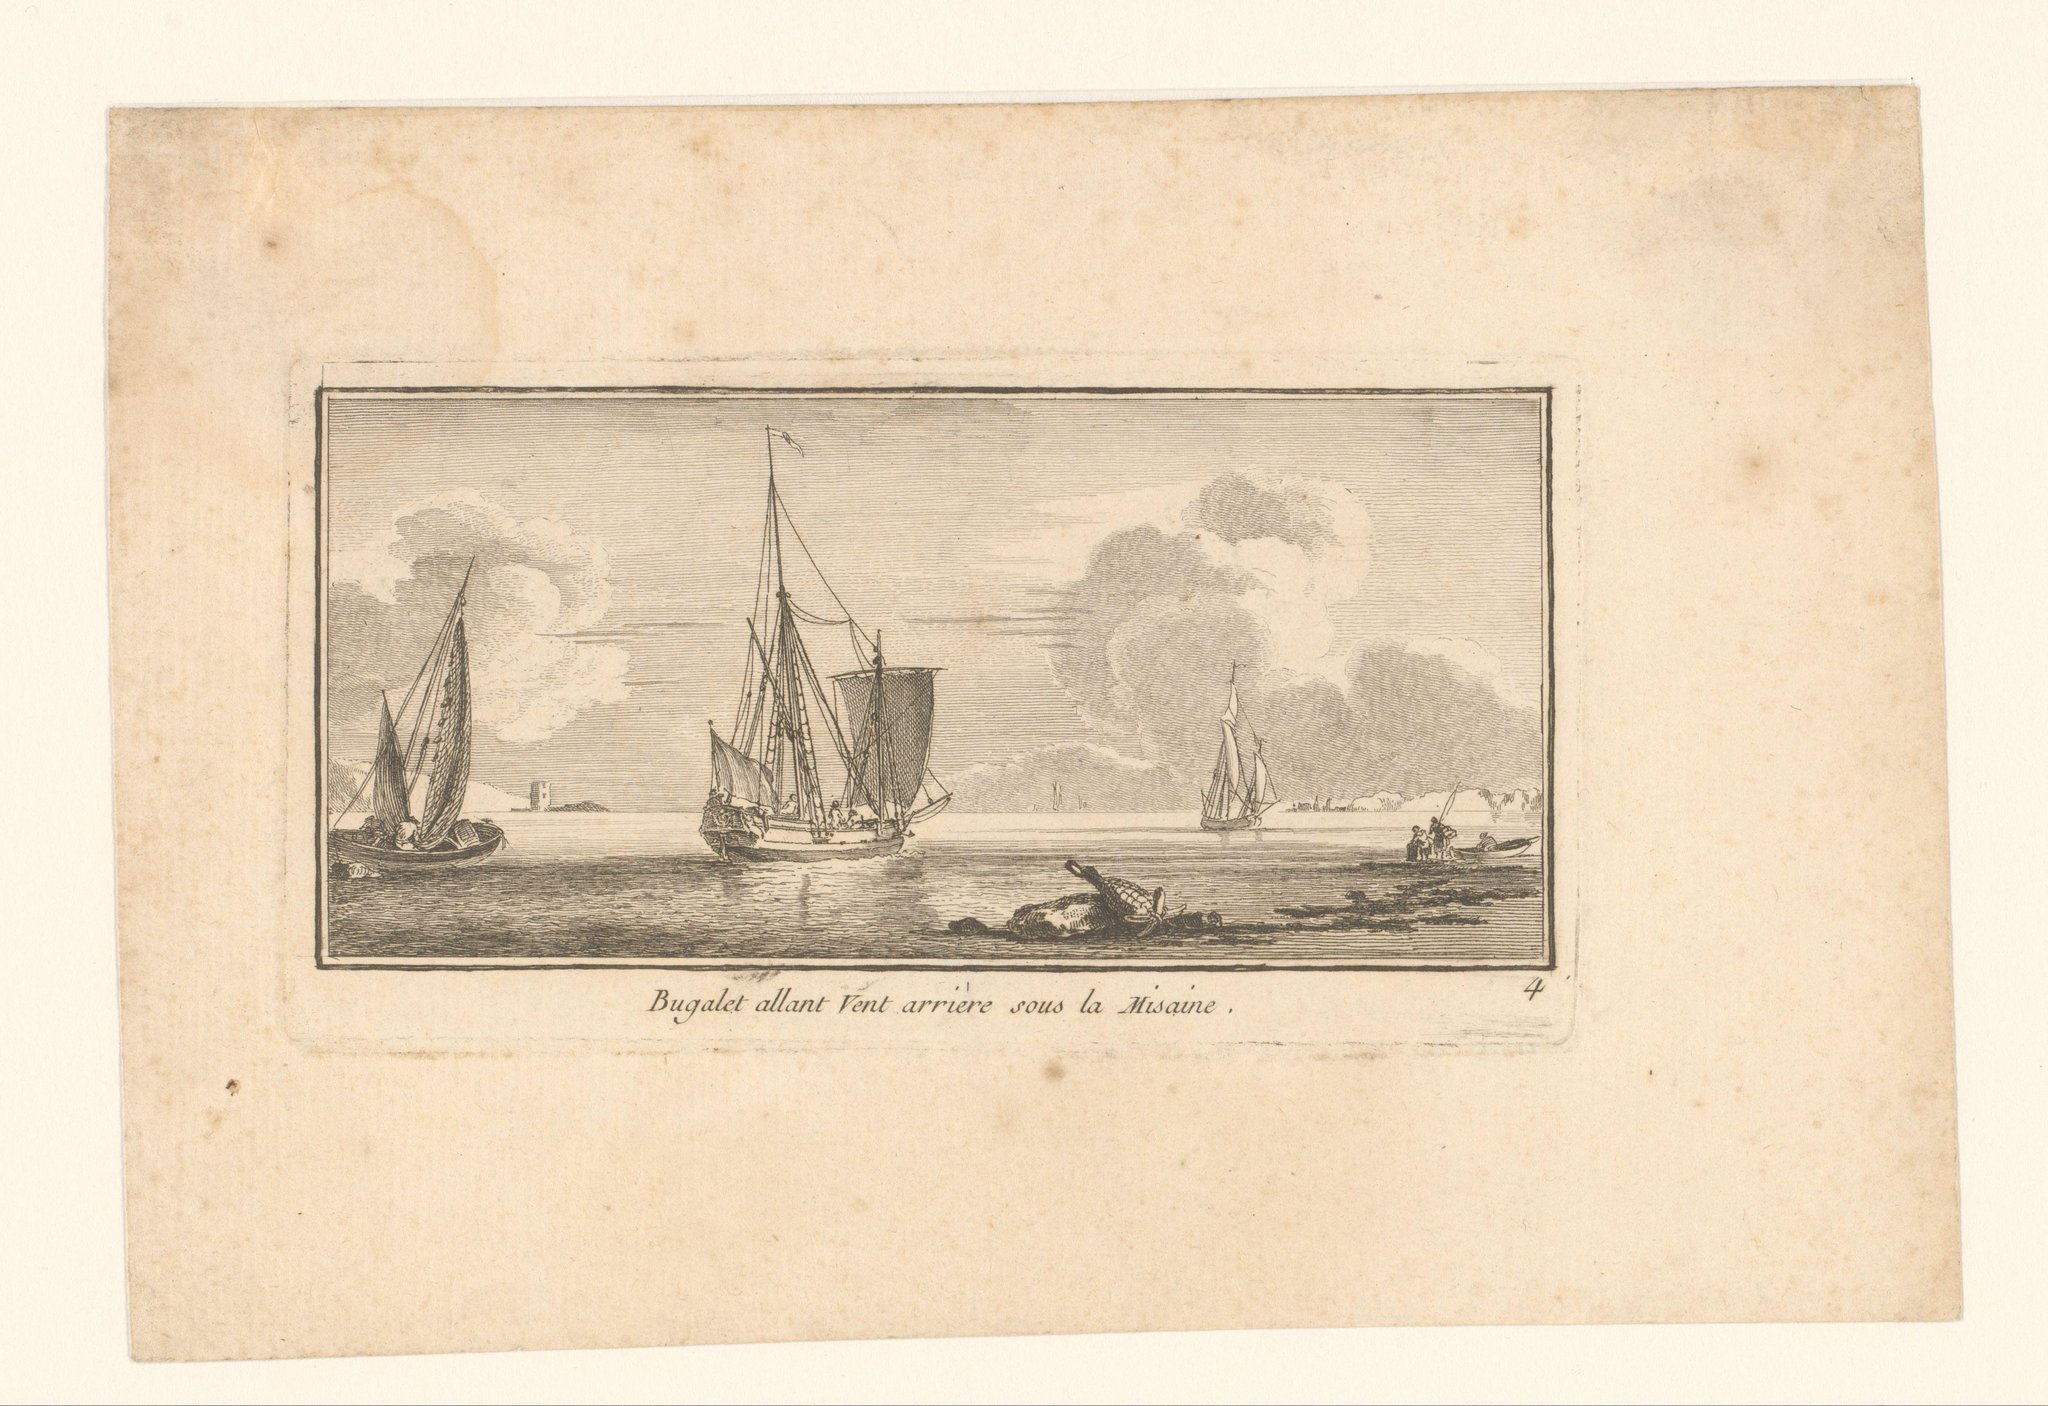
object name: print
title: Bugalet allant Vent arrière sous la Misaine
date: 1780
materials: paper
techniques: etching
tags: sailing-ship, sailing-boat, coast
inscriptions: collector's mark: Lugt 2228